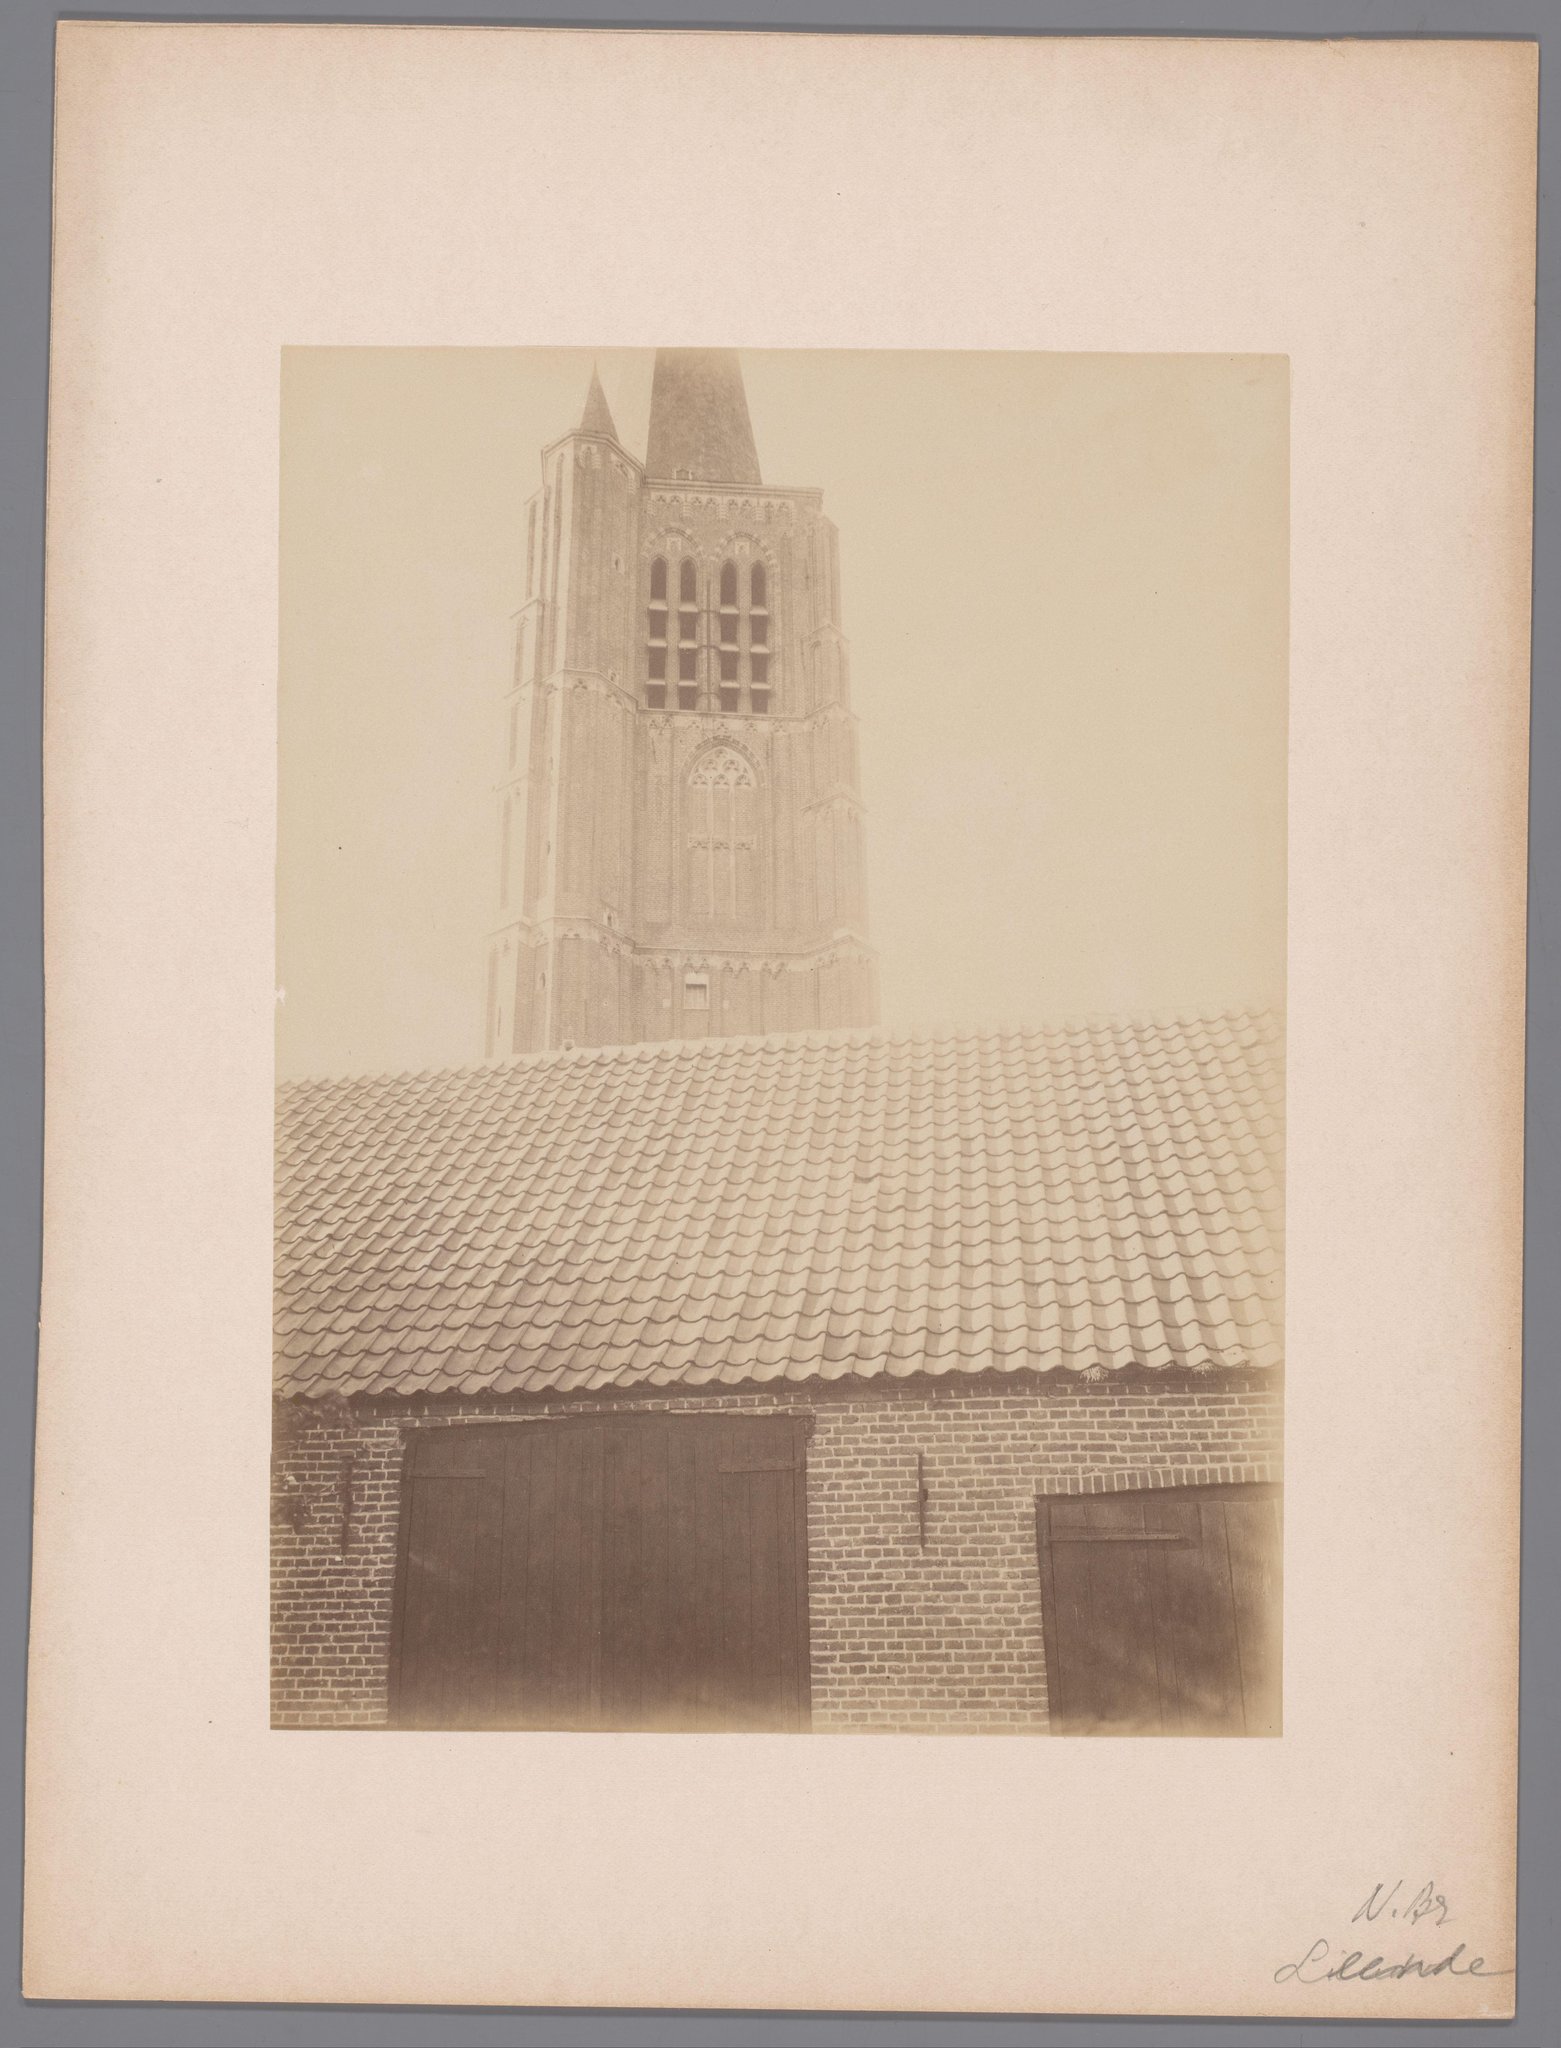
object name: photograph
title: Toren van de Sint-Petrus'-Bandenkerk te Leende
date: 1904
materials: cardboard, photographic support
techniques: albumen print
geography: leende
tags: church (exterior)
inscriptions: annotation: ‘Leende (N.B.) / Toren a/d R K Kerk / Juli 1904/ N B K-R’, annotation: ‘N.Br.’